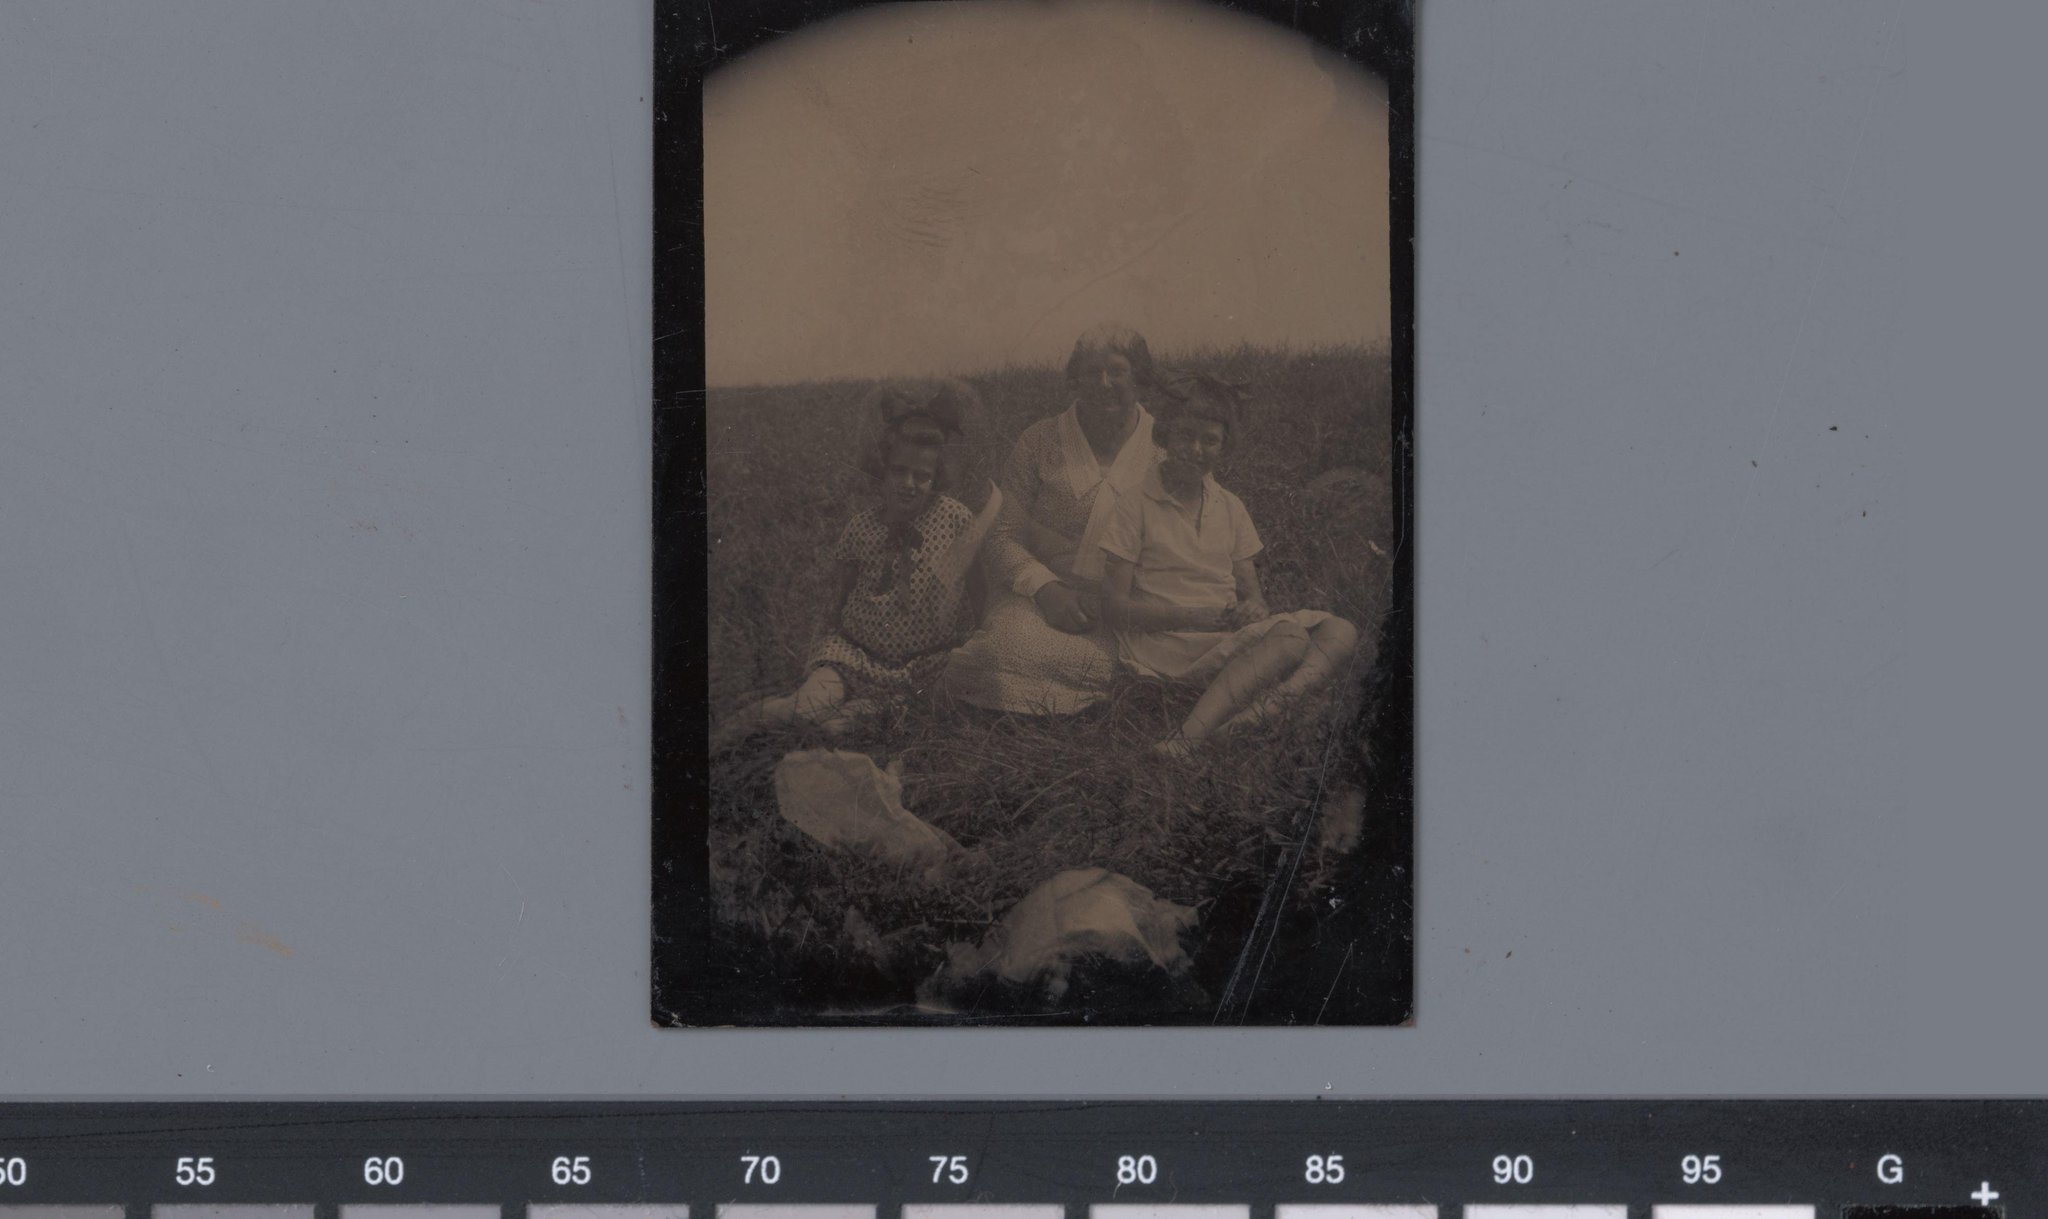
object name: photograph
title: Portret van een onbekende zittende vrouw en twee onbekende meisjes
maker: Anonymous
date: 1855-1940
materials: iron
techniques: ferrotyping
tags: historical persons - bb - woman, girl (child between toddler and youth) (+ two persons)